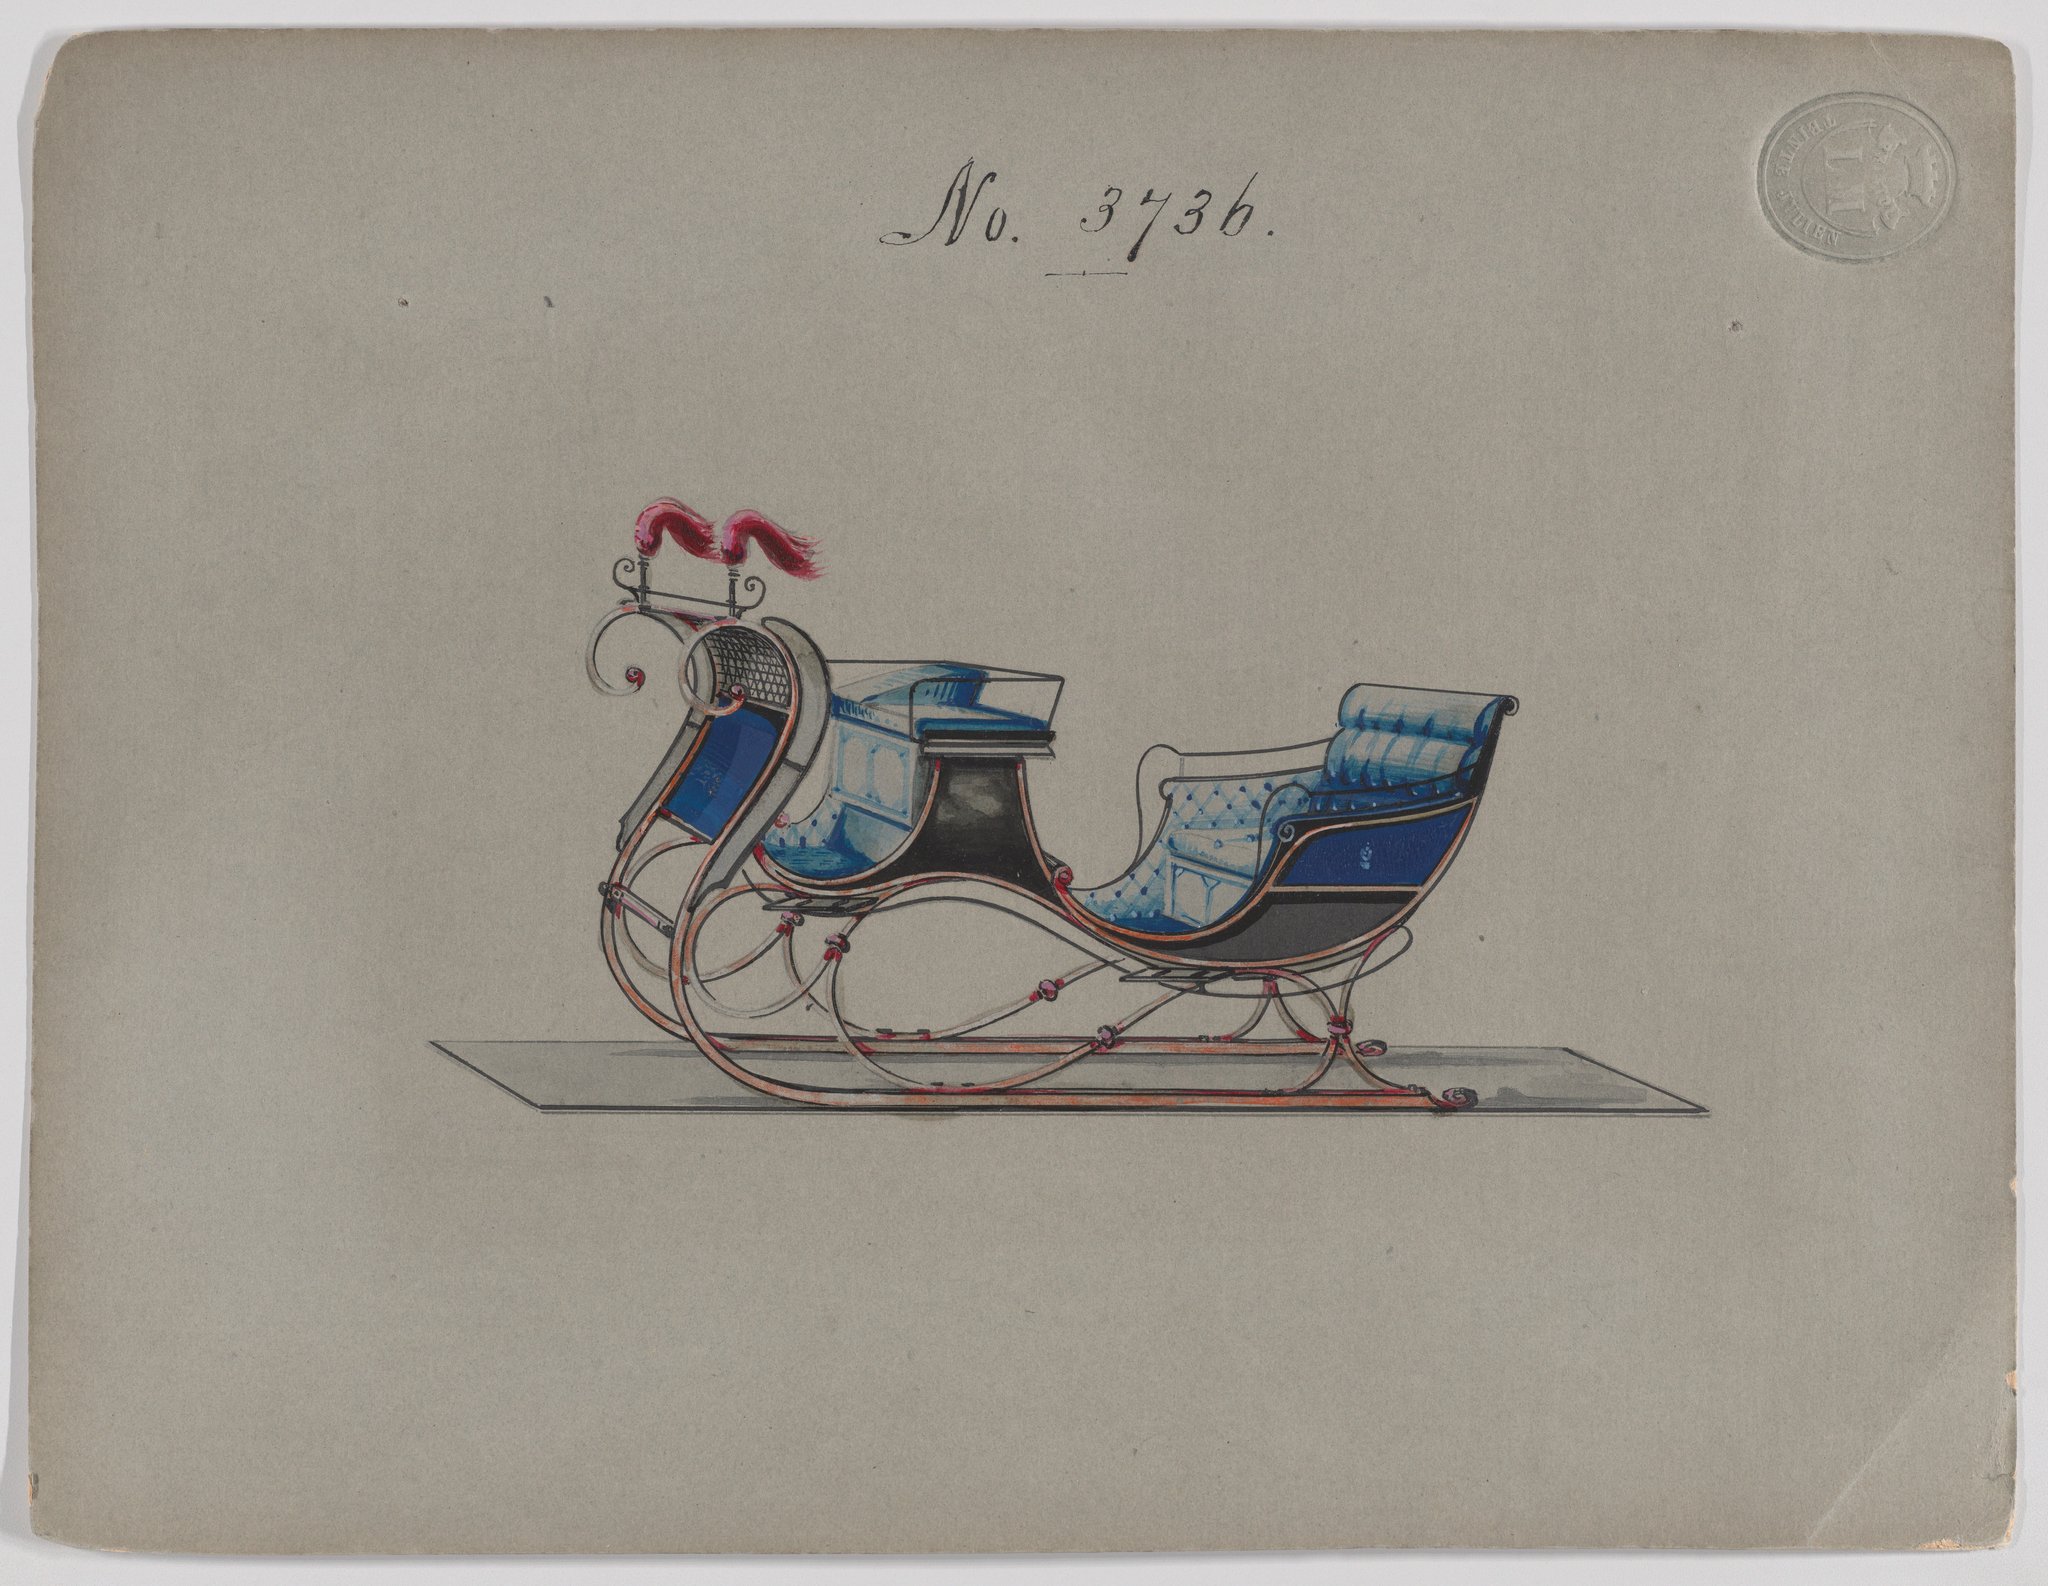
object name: drawing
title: Design for Victoria Sleigh, no. 3736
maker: brewster & co.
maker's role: manufacturer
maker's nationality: american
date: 1882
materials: gouache, gum arabic, ink, watercolor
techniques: pen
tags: sleighs